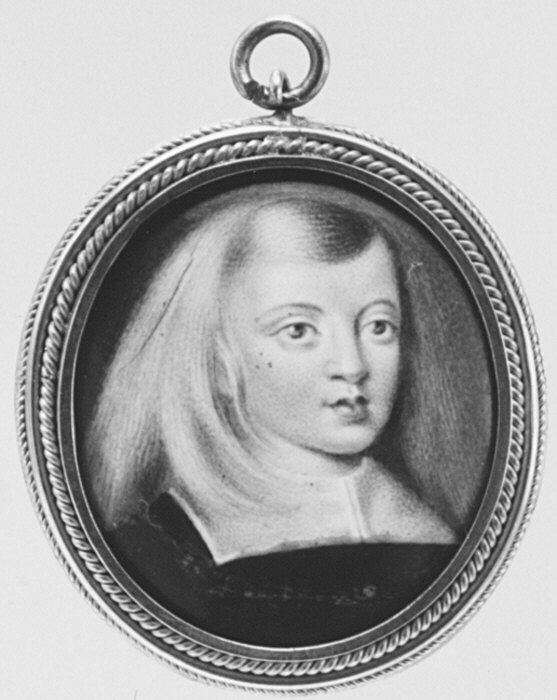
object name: painting, miniature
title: Portrait of a Child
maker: continental painter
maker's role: artist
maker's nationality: continental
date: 1645-1655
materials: enamel, gold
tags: children,portraits